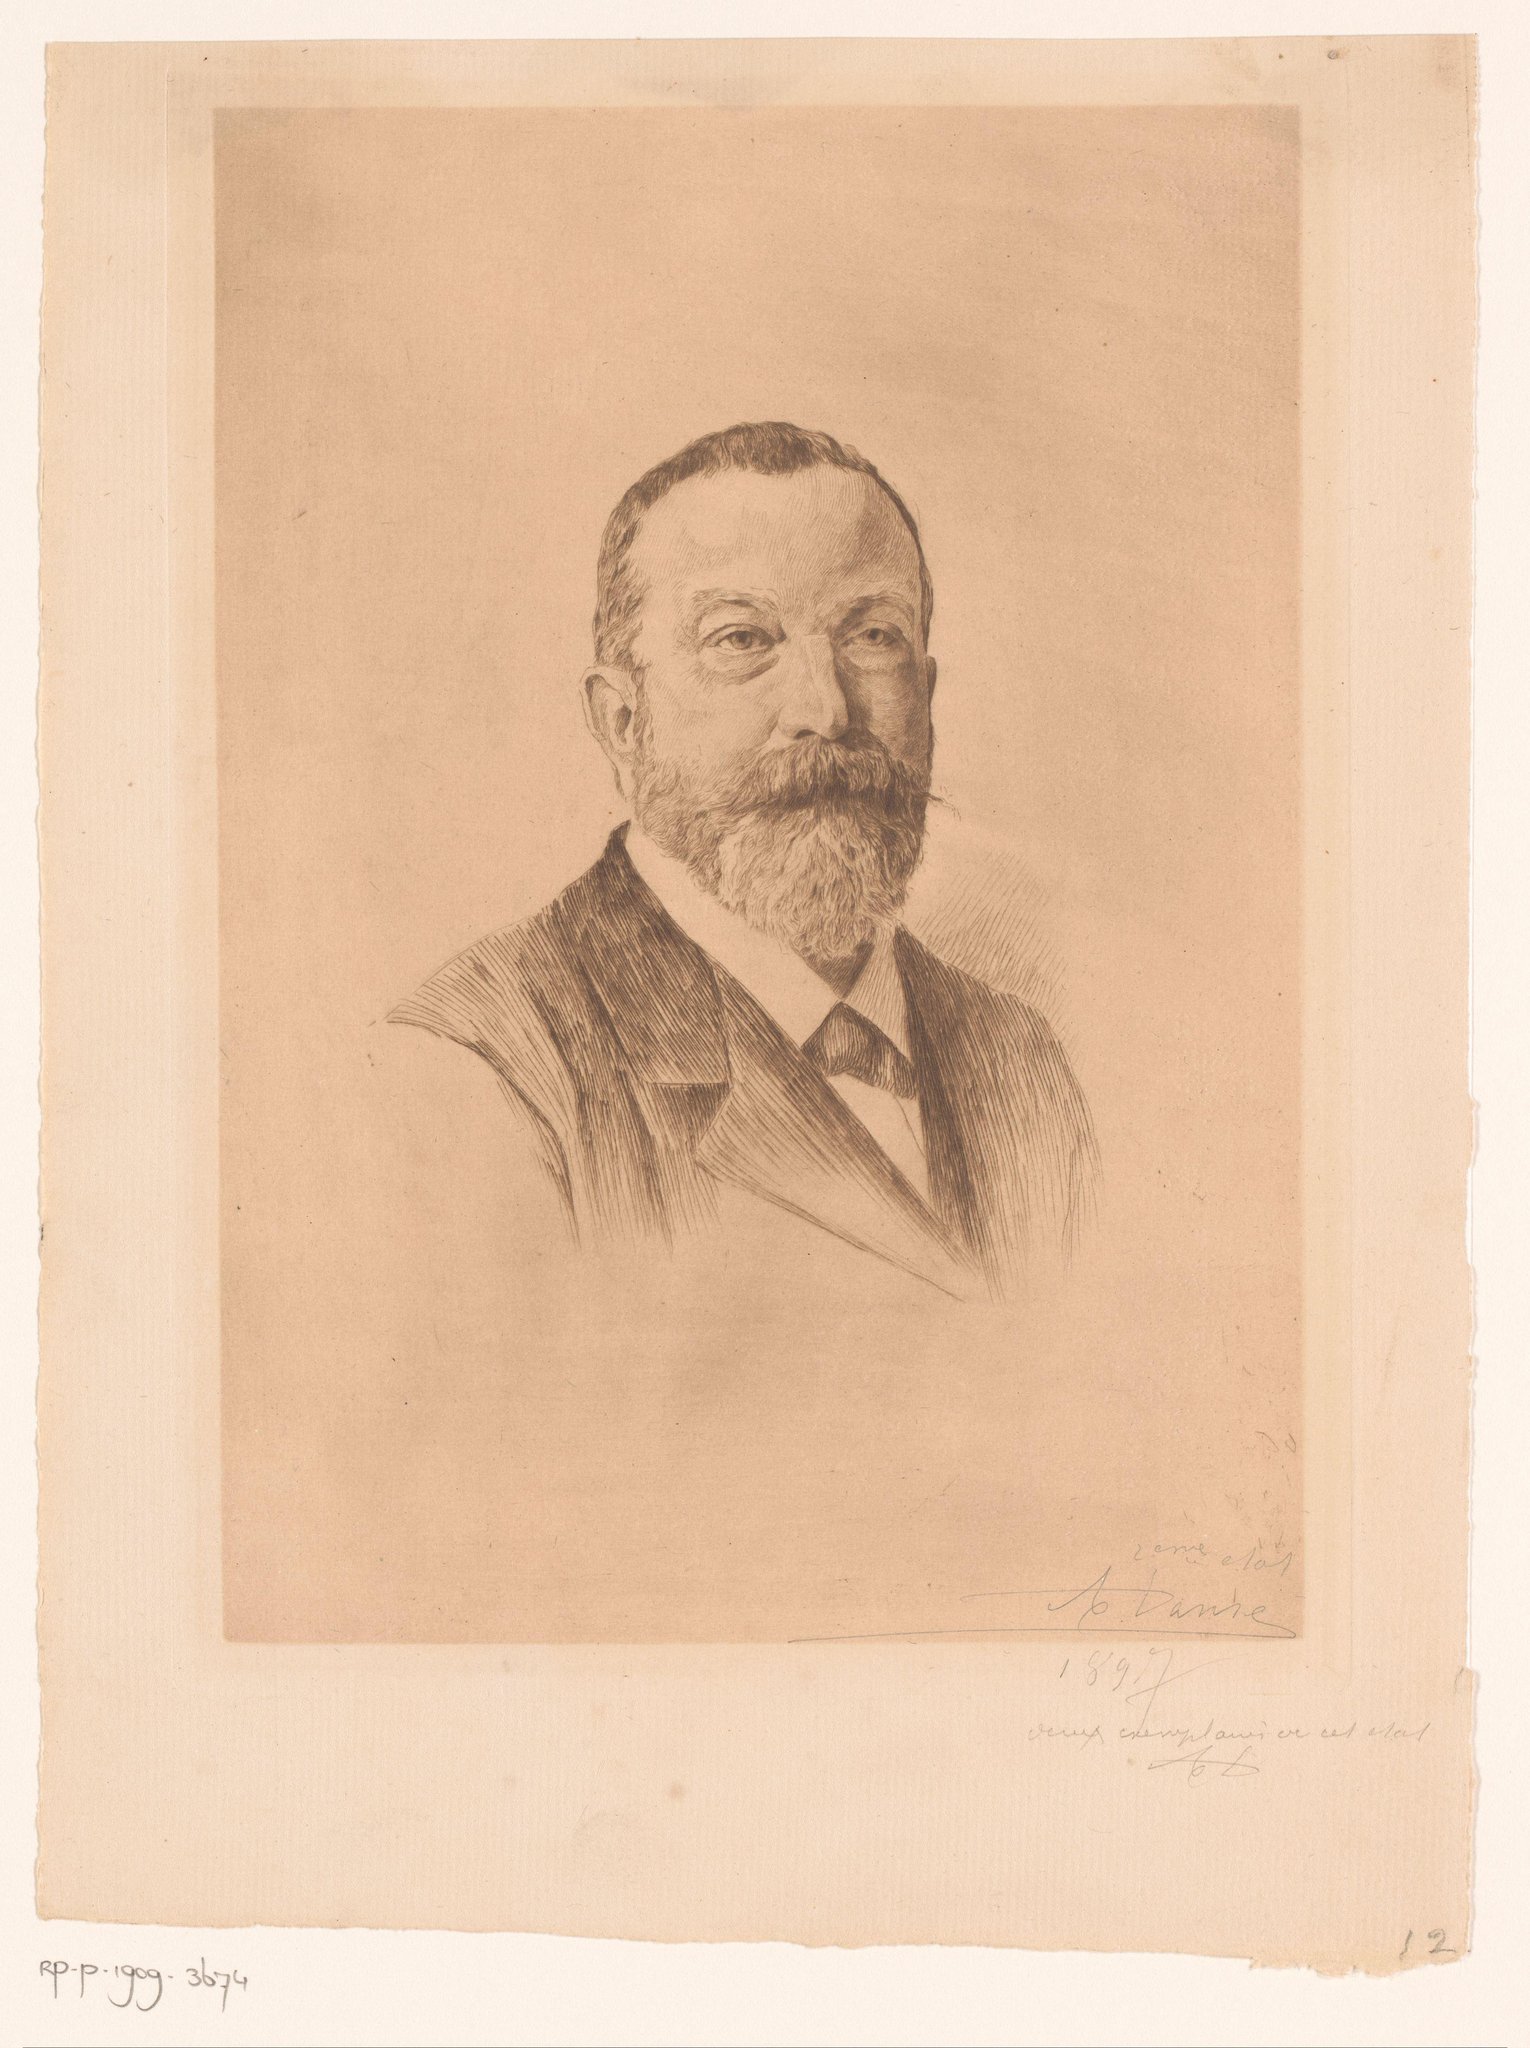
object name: print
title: Portret van een onbekende man, mogelijk de Parijse ingenieur Wittman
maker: auguste danse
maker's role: print maker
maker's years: 1829-1929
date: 1897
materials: paper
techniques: drypoint, etching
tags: anonymous historical person portrayed alone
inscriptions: annotation: ‘2eme etat; deux exemplaires de cet etat’, collector's mark: Lugt 2228, watermark: ‘Franse lelie in een wapenschild boven monogram V.G.Z.’